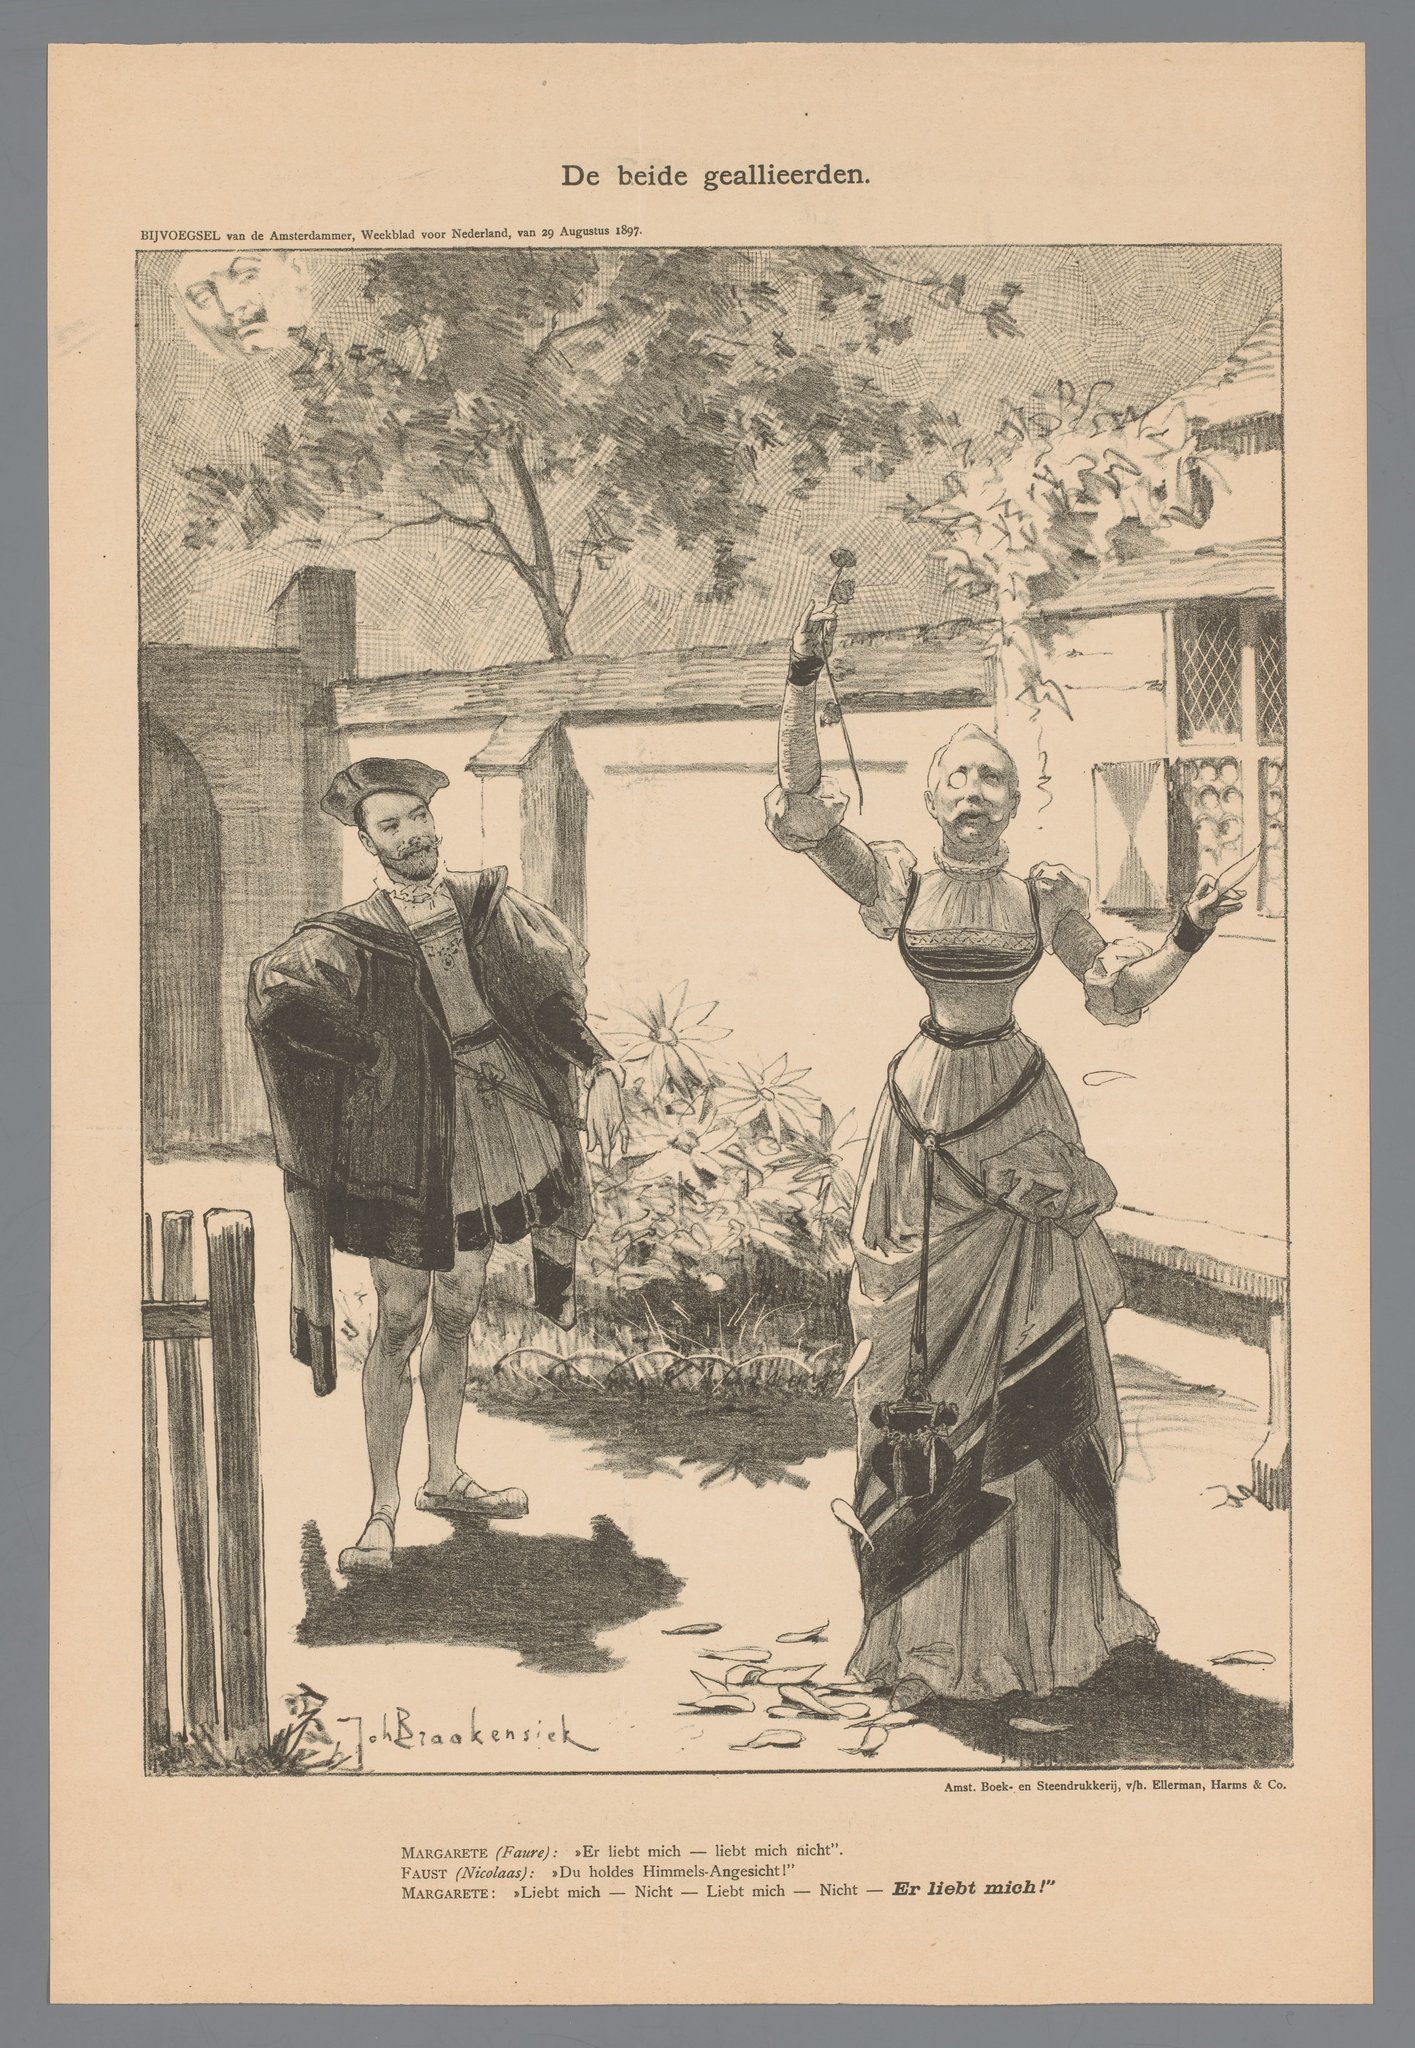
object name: cartoon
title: De beide geallieerden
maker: johan braakensiek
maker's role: draughtsman, print maker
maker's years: 1858-1940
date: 1897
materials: paper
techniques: lithograph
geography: amsterdam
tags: paris, names of literary characters, historical persons, female literary characters, (scenes from) specific works of literature: goethe, faust, political caricatures and satires, alliance, league, union, foedus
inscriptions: date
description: Prent uit het bijvoegsel van: De Amsterdammer. Weekblad voor Nederland, 29 augustus 1897.